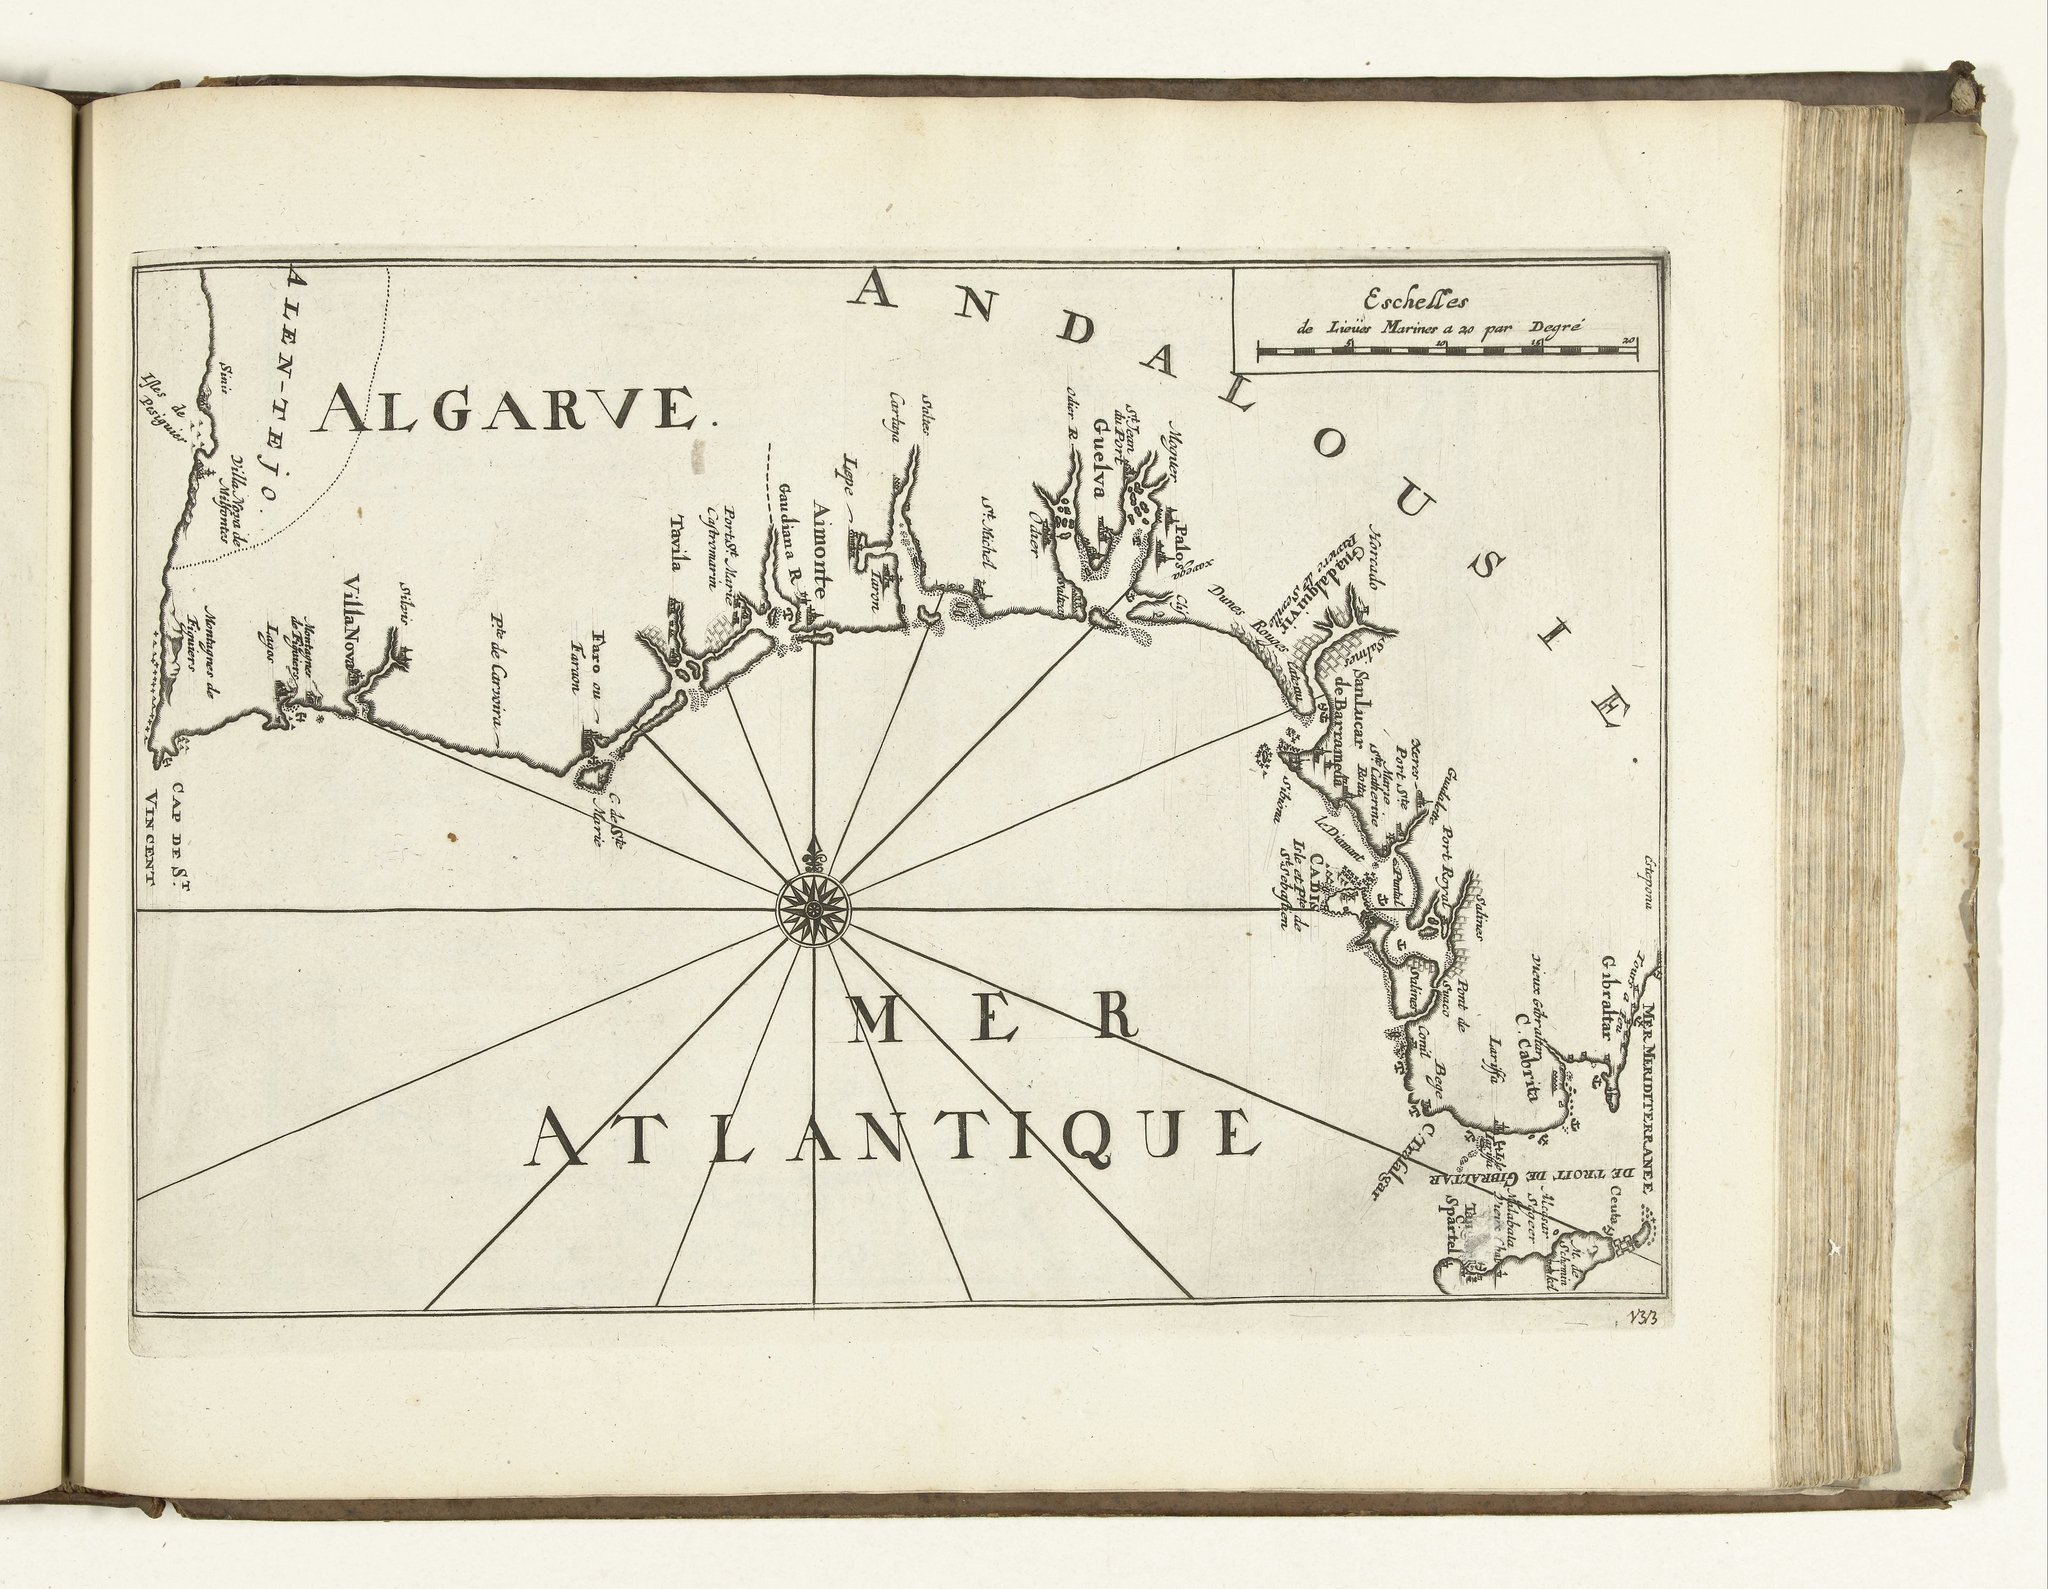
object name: map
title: Les Forces de l'Europe, Asie, Afrique et Amerique (...) Comme aussi les Cartes des Côtes de France et d'Espagne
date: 1726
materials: paper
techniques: engraving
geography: leiden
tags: maps of separate countries or regions, spain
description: Kaart van de zuidkust van Portugal en Spanje van de Algarve tot aan Gibraltar. Plaat nr. 133 in deel VI van het prentwerk: Les Forces de l'Europe, Asie, Afrique et Amerique ... Comme aussi les Cartes des Côtes de France et d'Espagne uit 1726, dit eerste deel met 238 met de hand genummerde platen van vermaarde sterke steden en vestingen in het kader van de Spaanse Successieoorlog 1701-1713. Voor het merendeel zijn deze platen gekopieerd naar de anonieme Franse platen van vermaarde sterke steden en vestingen: in Les forces de l'Europe en in: Le theatre de la guerre, dans les Pays-Bas, beide oorspronkelijk uitgegeven door Nicolas de Fer te Parijs (1693-1697) in het kader van de Negenjarige Oorlog. Opschriften in het Frans.